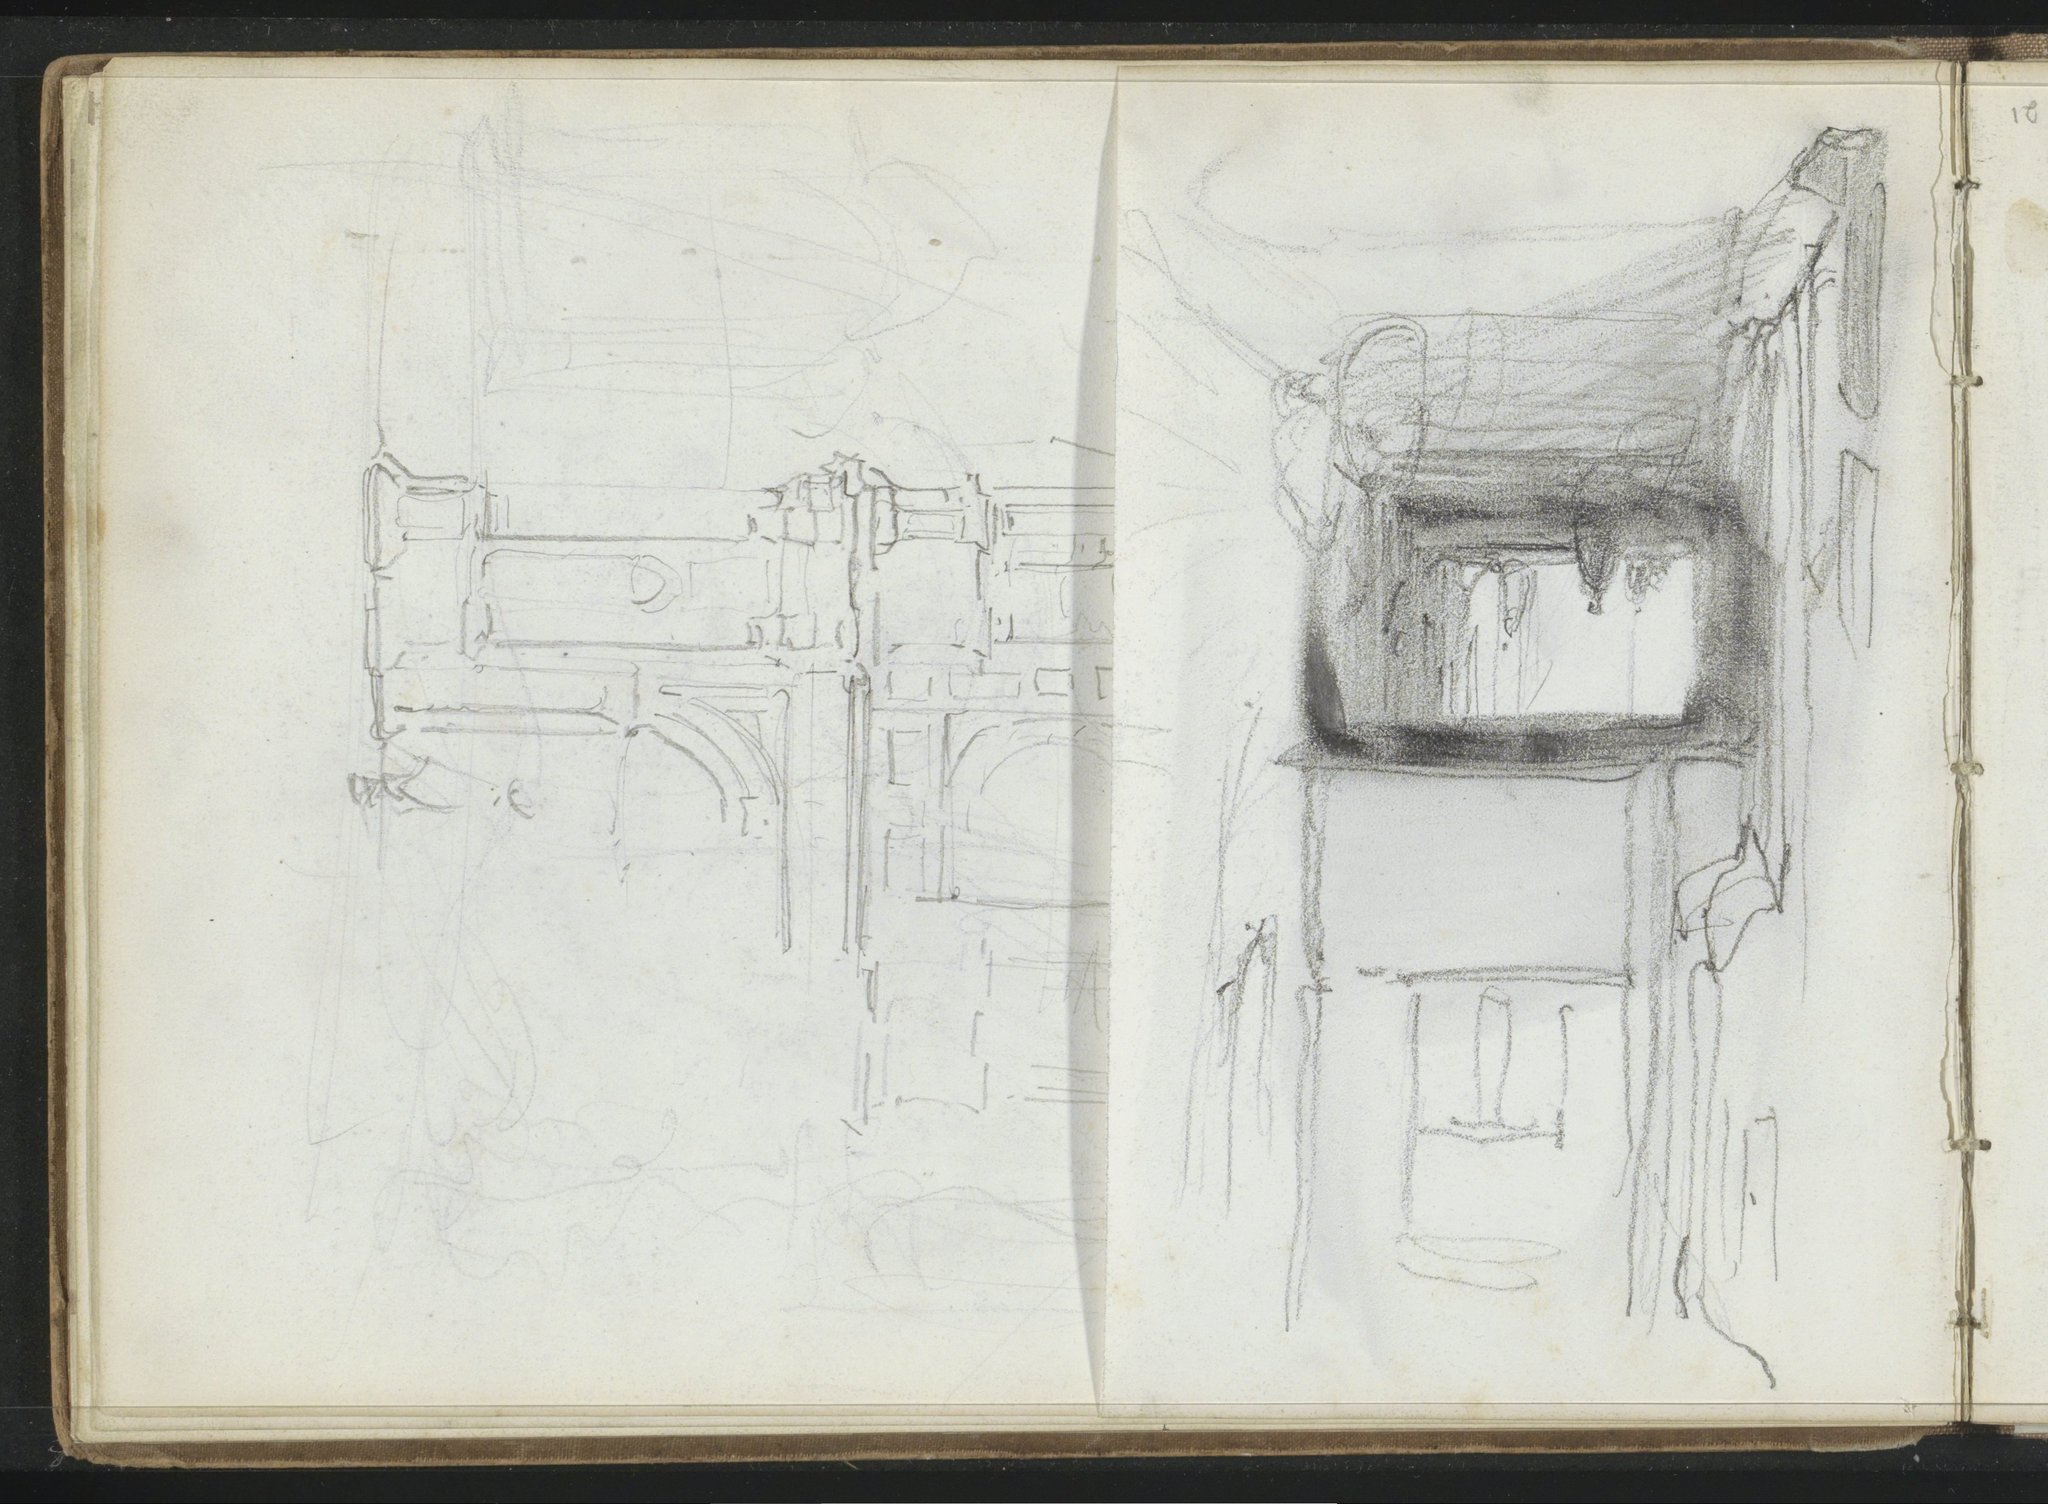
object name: sketchbook leaf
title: Figuren in een deels overdekte steeg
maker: johannes bosboom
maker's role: draughtsman, painter, print maker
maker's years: 1817-1891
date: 1827-1891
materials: paper, pencil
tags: street (+ city(-scape) with figures, staffage)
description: Blad 12 verso uit een schetsboek met 41 pagina's.